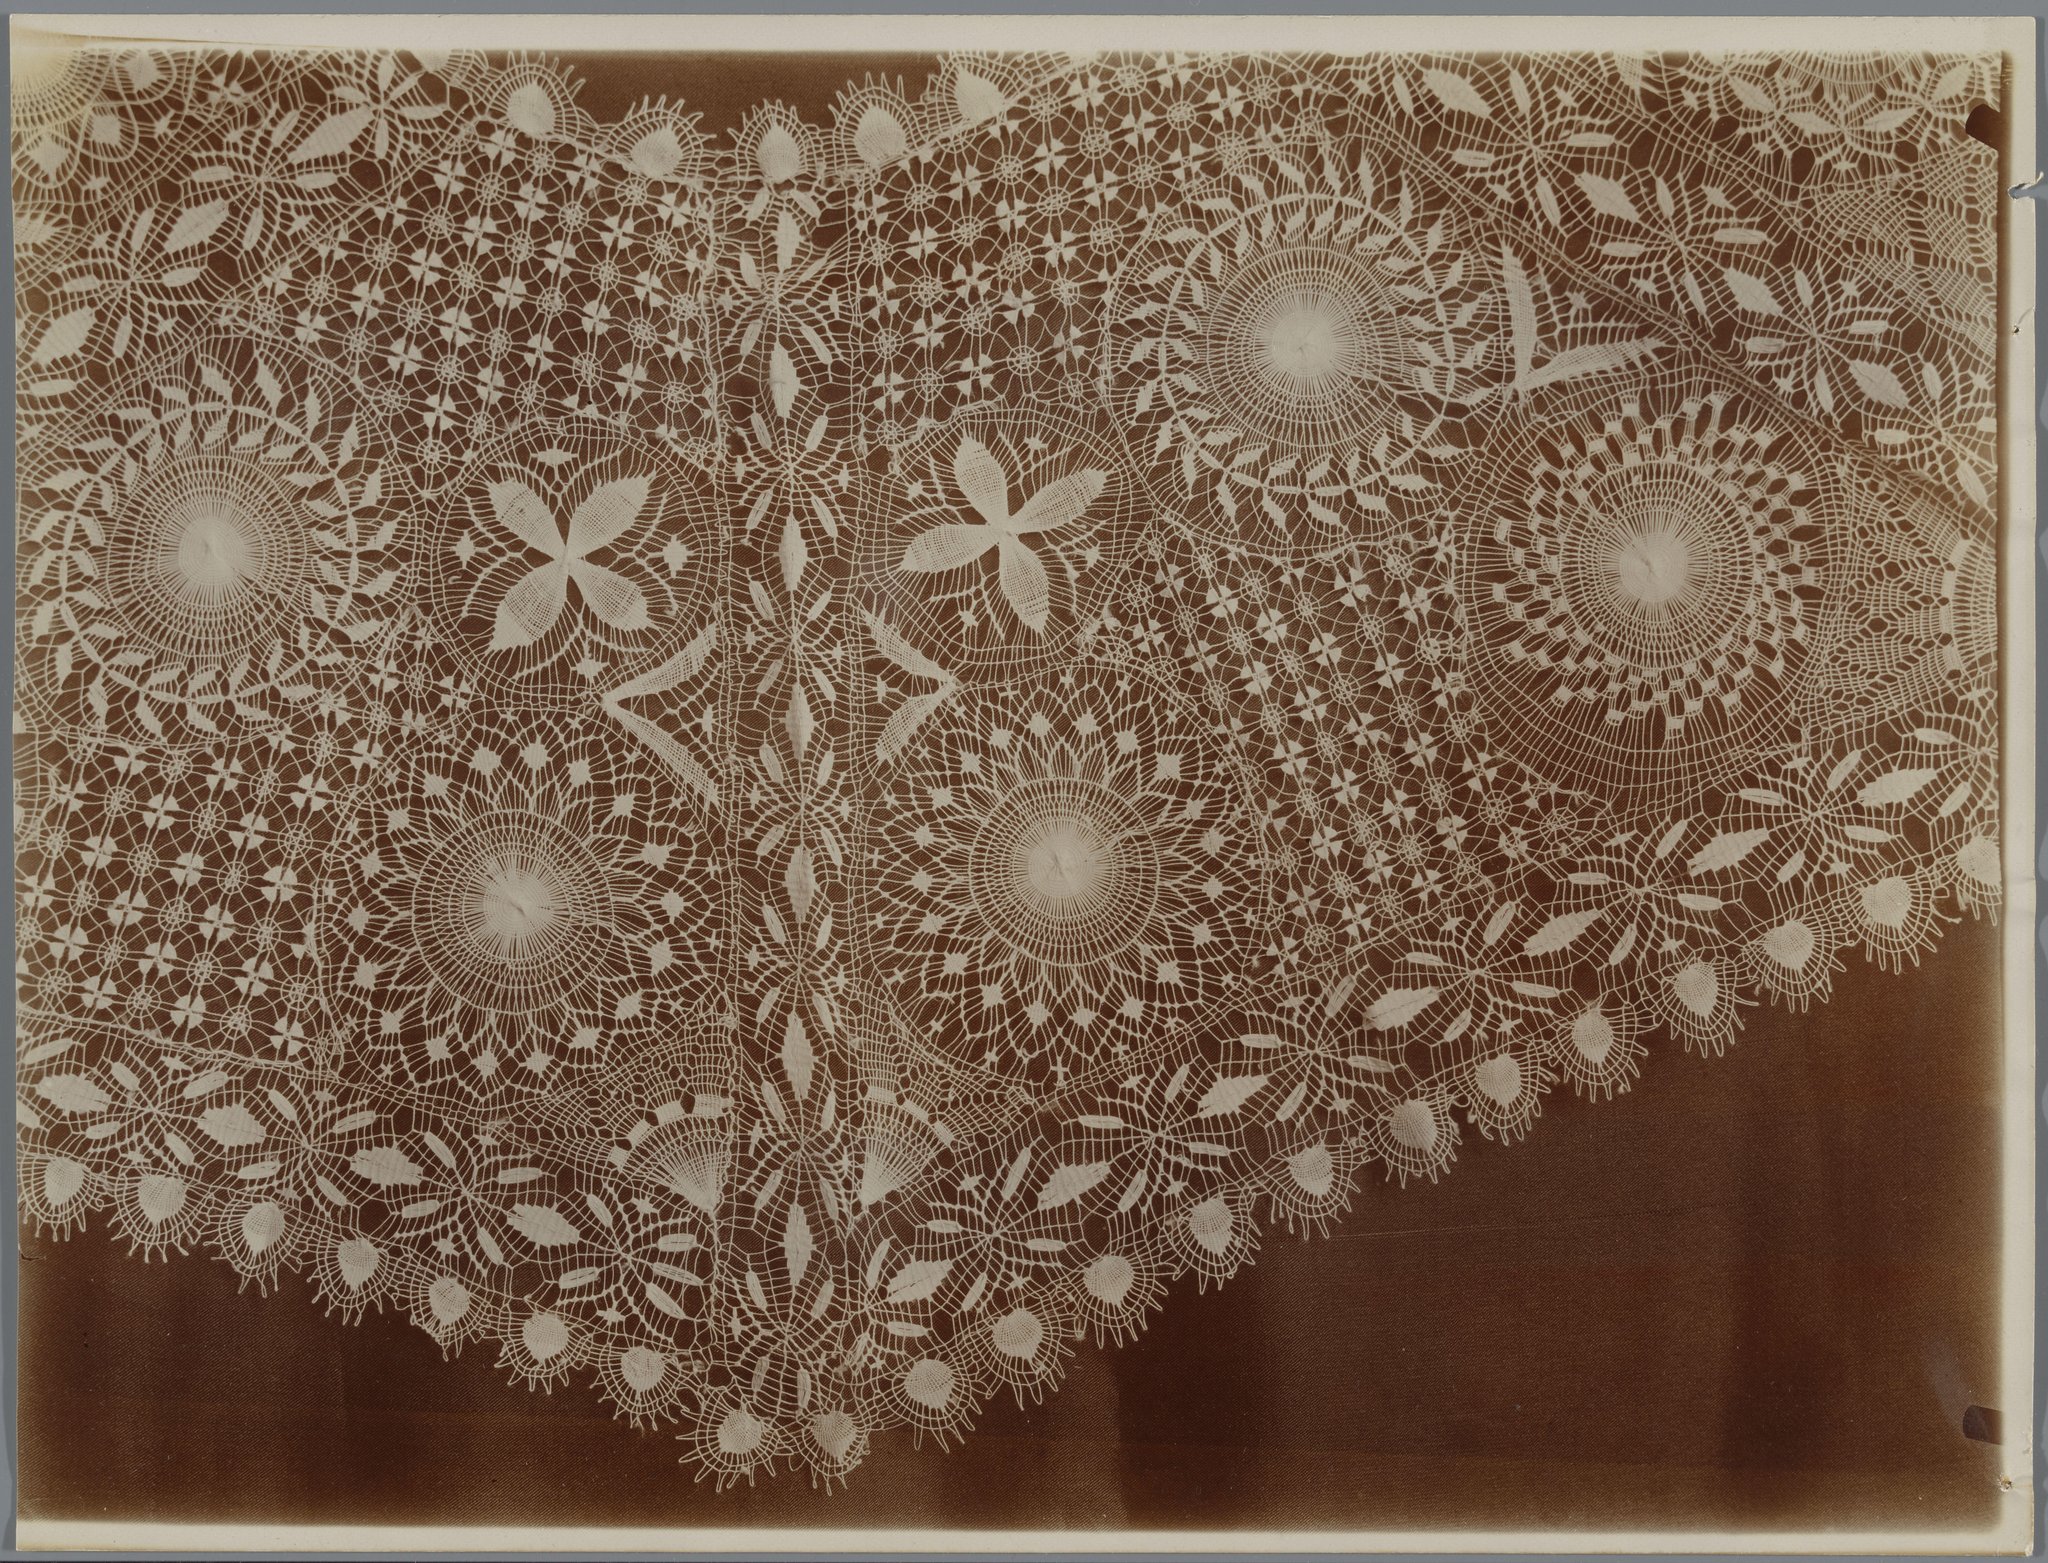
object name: photograph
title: Detail van een kanten doek, mogelijk een kraag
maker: Anonymous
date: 1890-1920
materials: paper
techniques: gelatin silver print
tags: lace